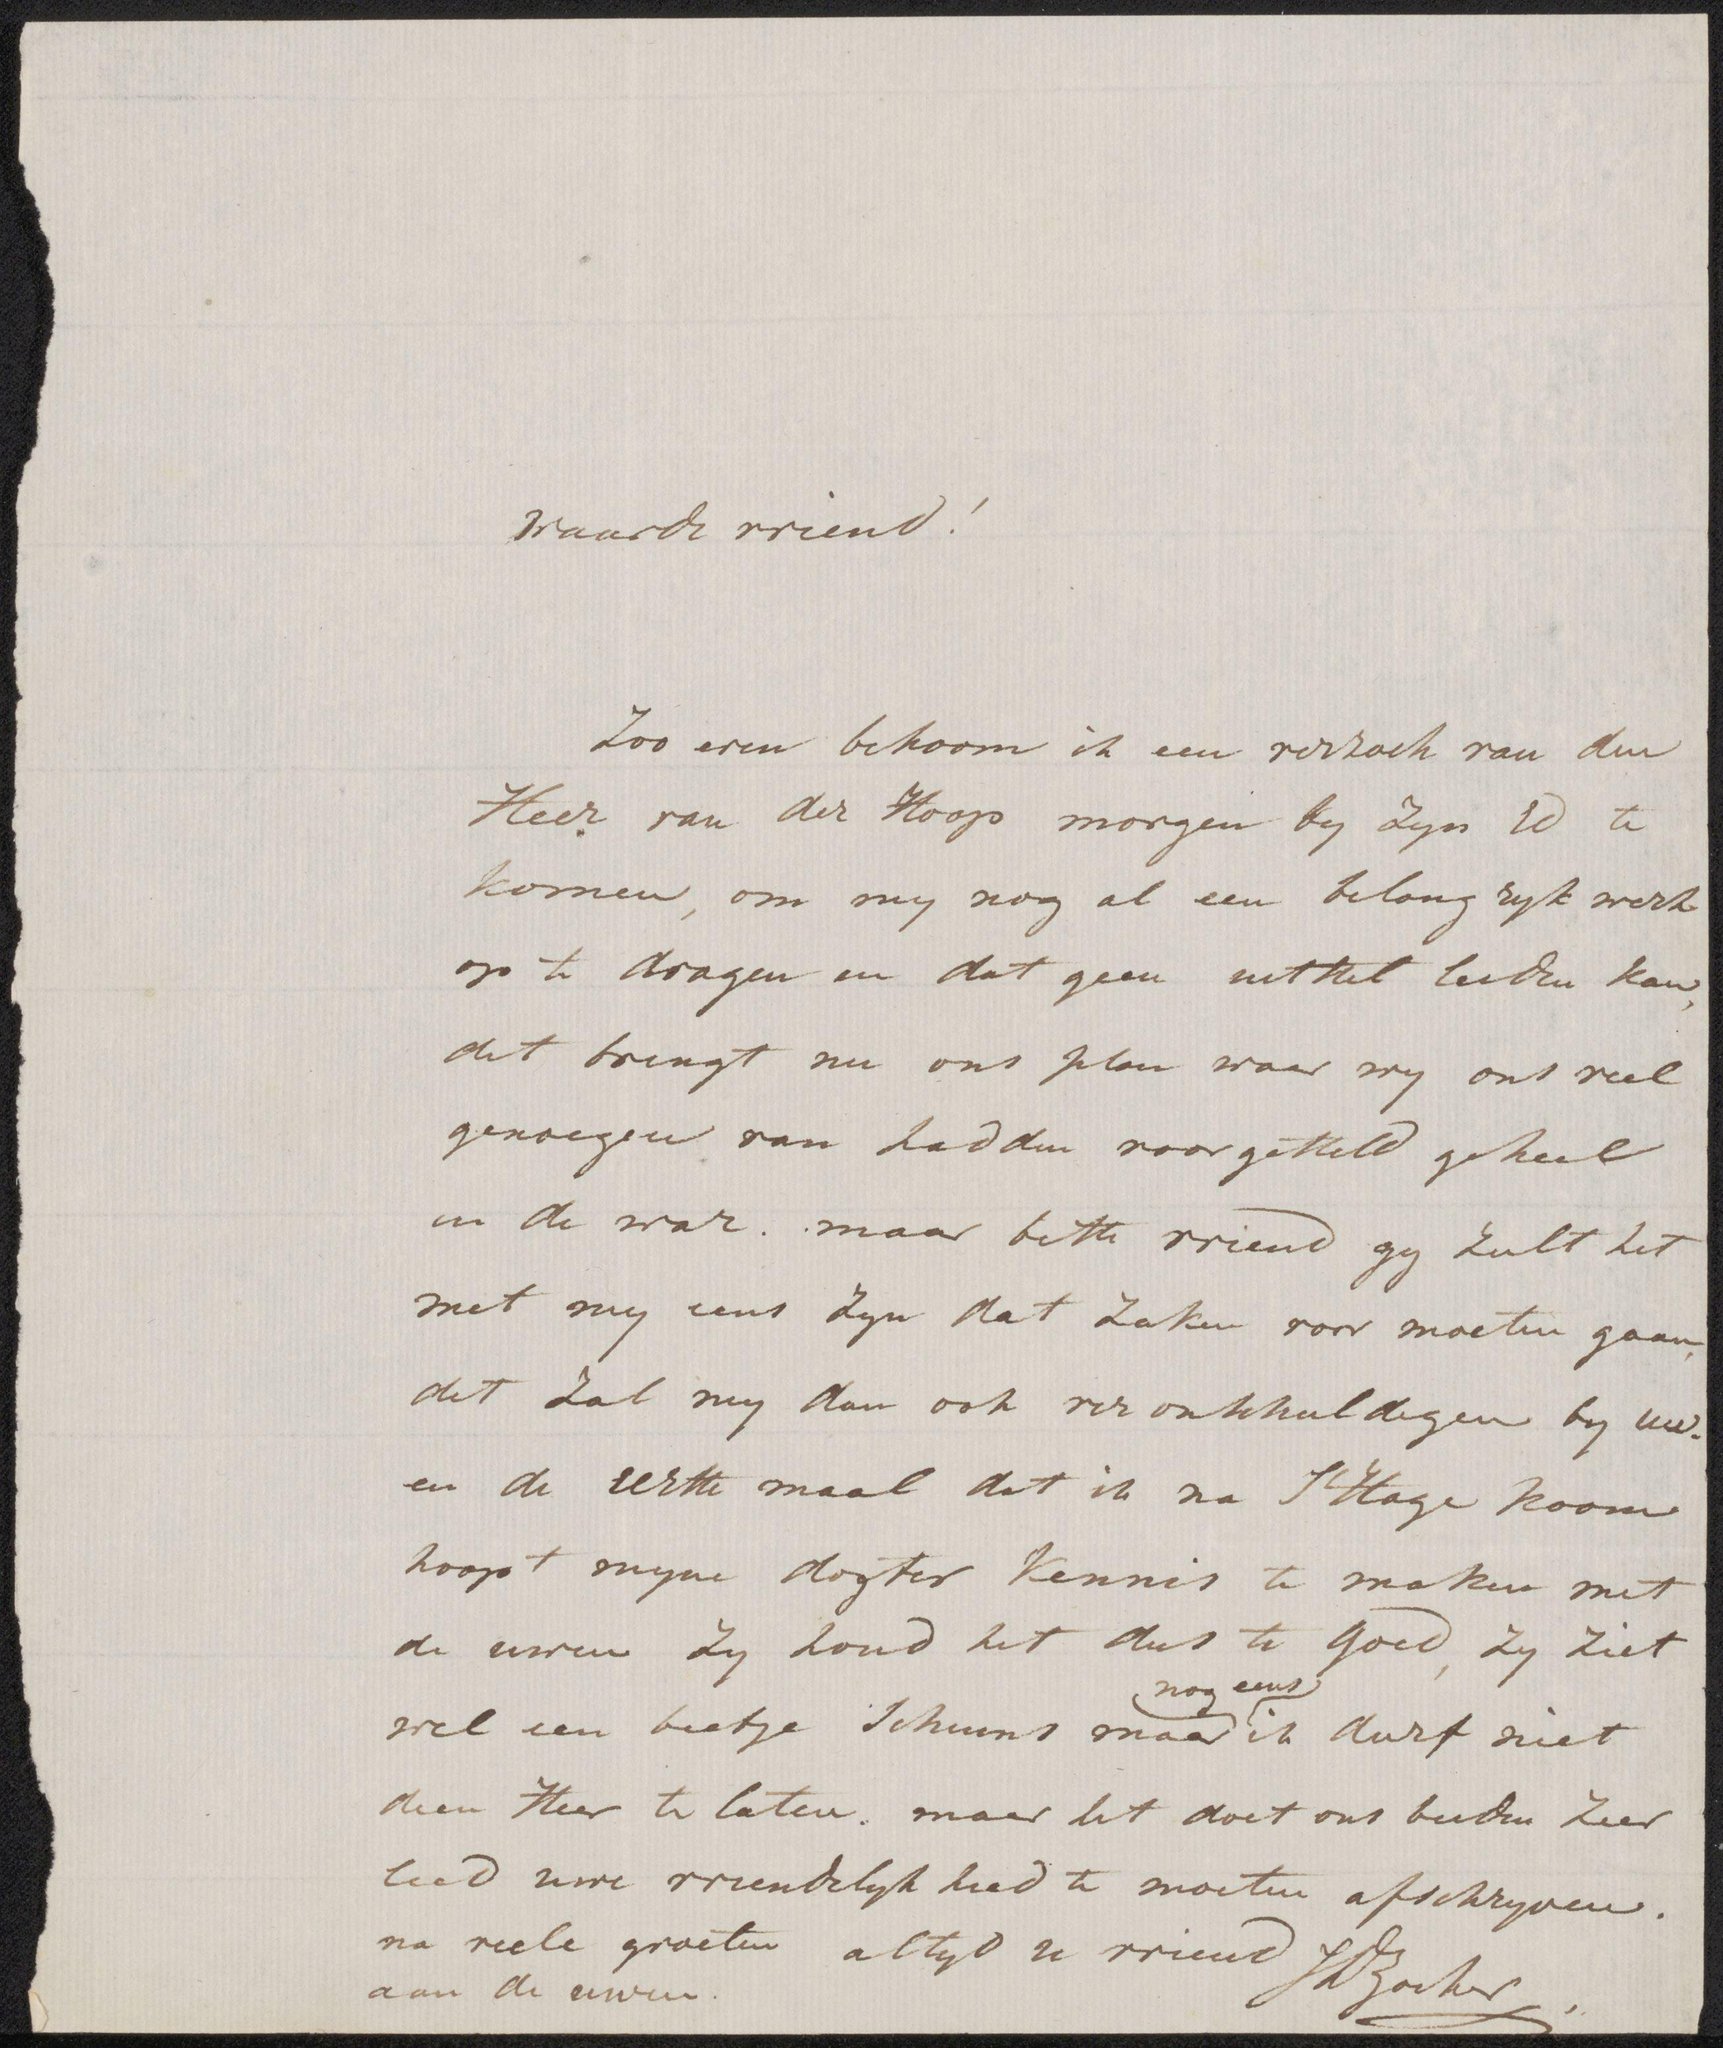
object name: letter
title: Brief aan anoniem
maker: johan david zocher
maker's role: designer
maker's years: 1791-1870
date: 1801-1870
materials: ink, paper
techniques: pen, writing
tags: family life, the hague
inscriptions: watermark